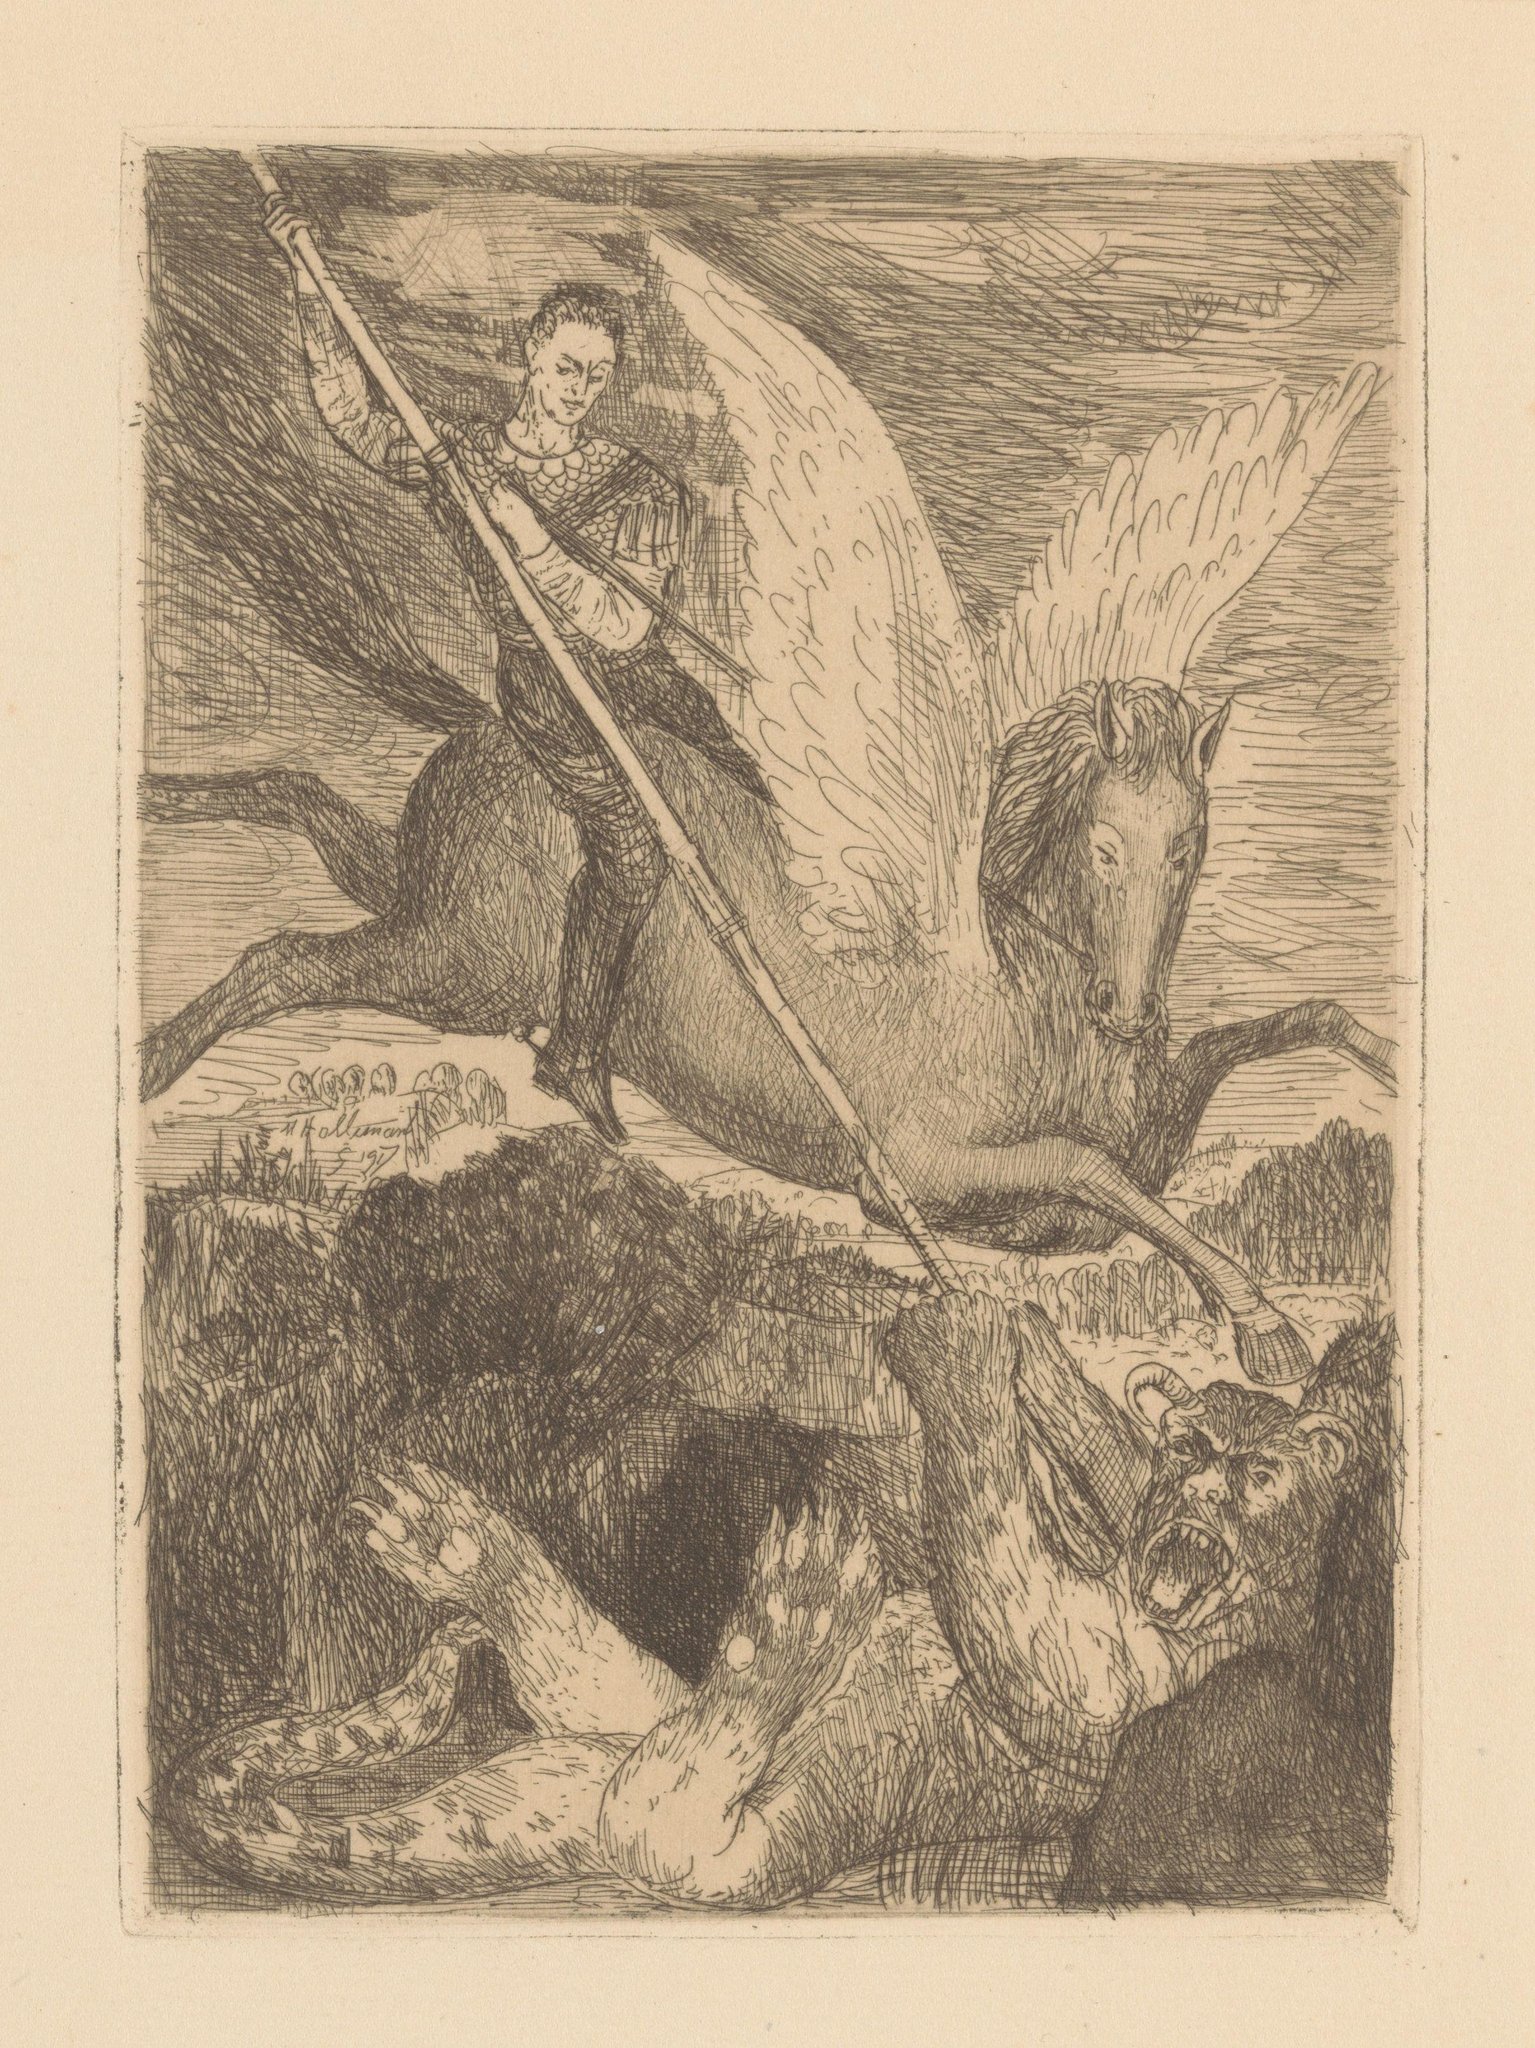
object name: print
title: Uit het leven van Bellerophon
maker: marius holleman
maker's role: draughtsman, print maker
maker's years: 1878-1926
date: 1917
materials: paper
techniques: etching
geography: groningen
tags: bellerophon, flying on pegasus' back, kills the chimera, a fire-breathing monster, with arrows or a spear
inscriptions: collector's mark: Lugt 2228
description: Zittend op Pegasus steekt Bellerophon een speer in de Chimaera.